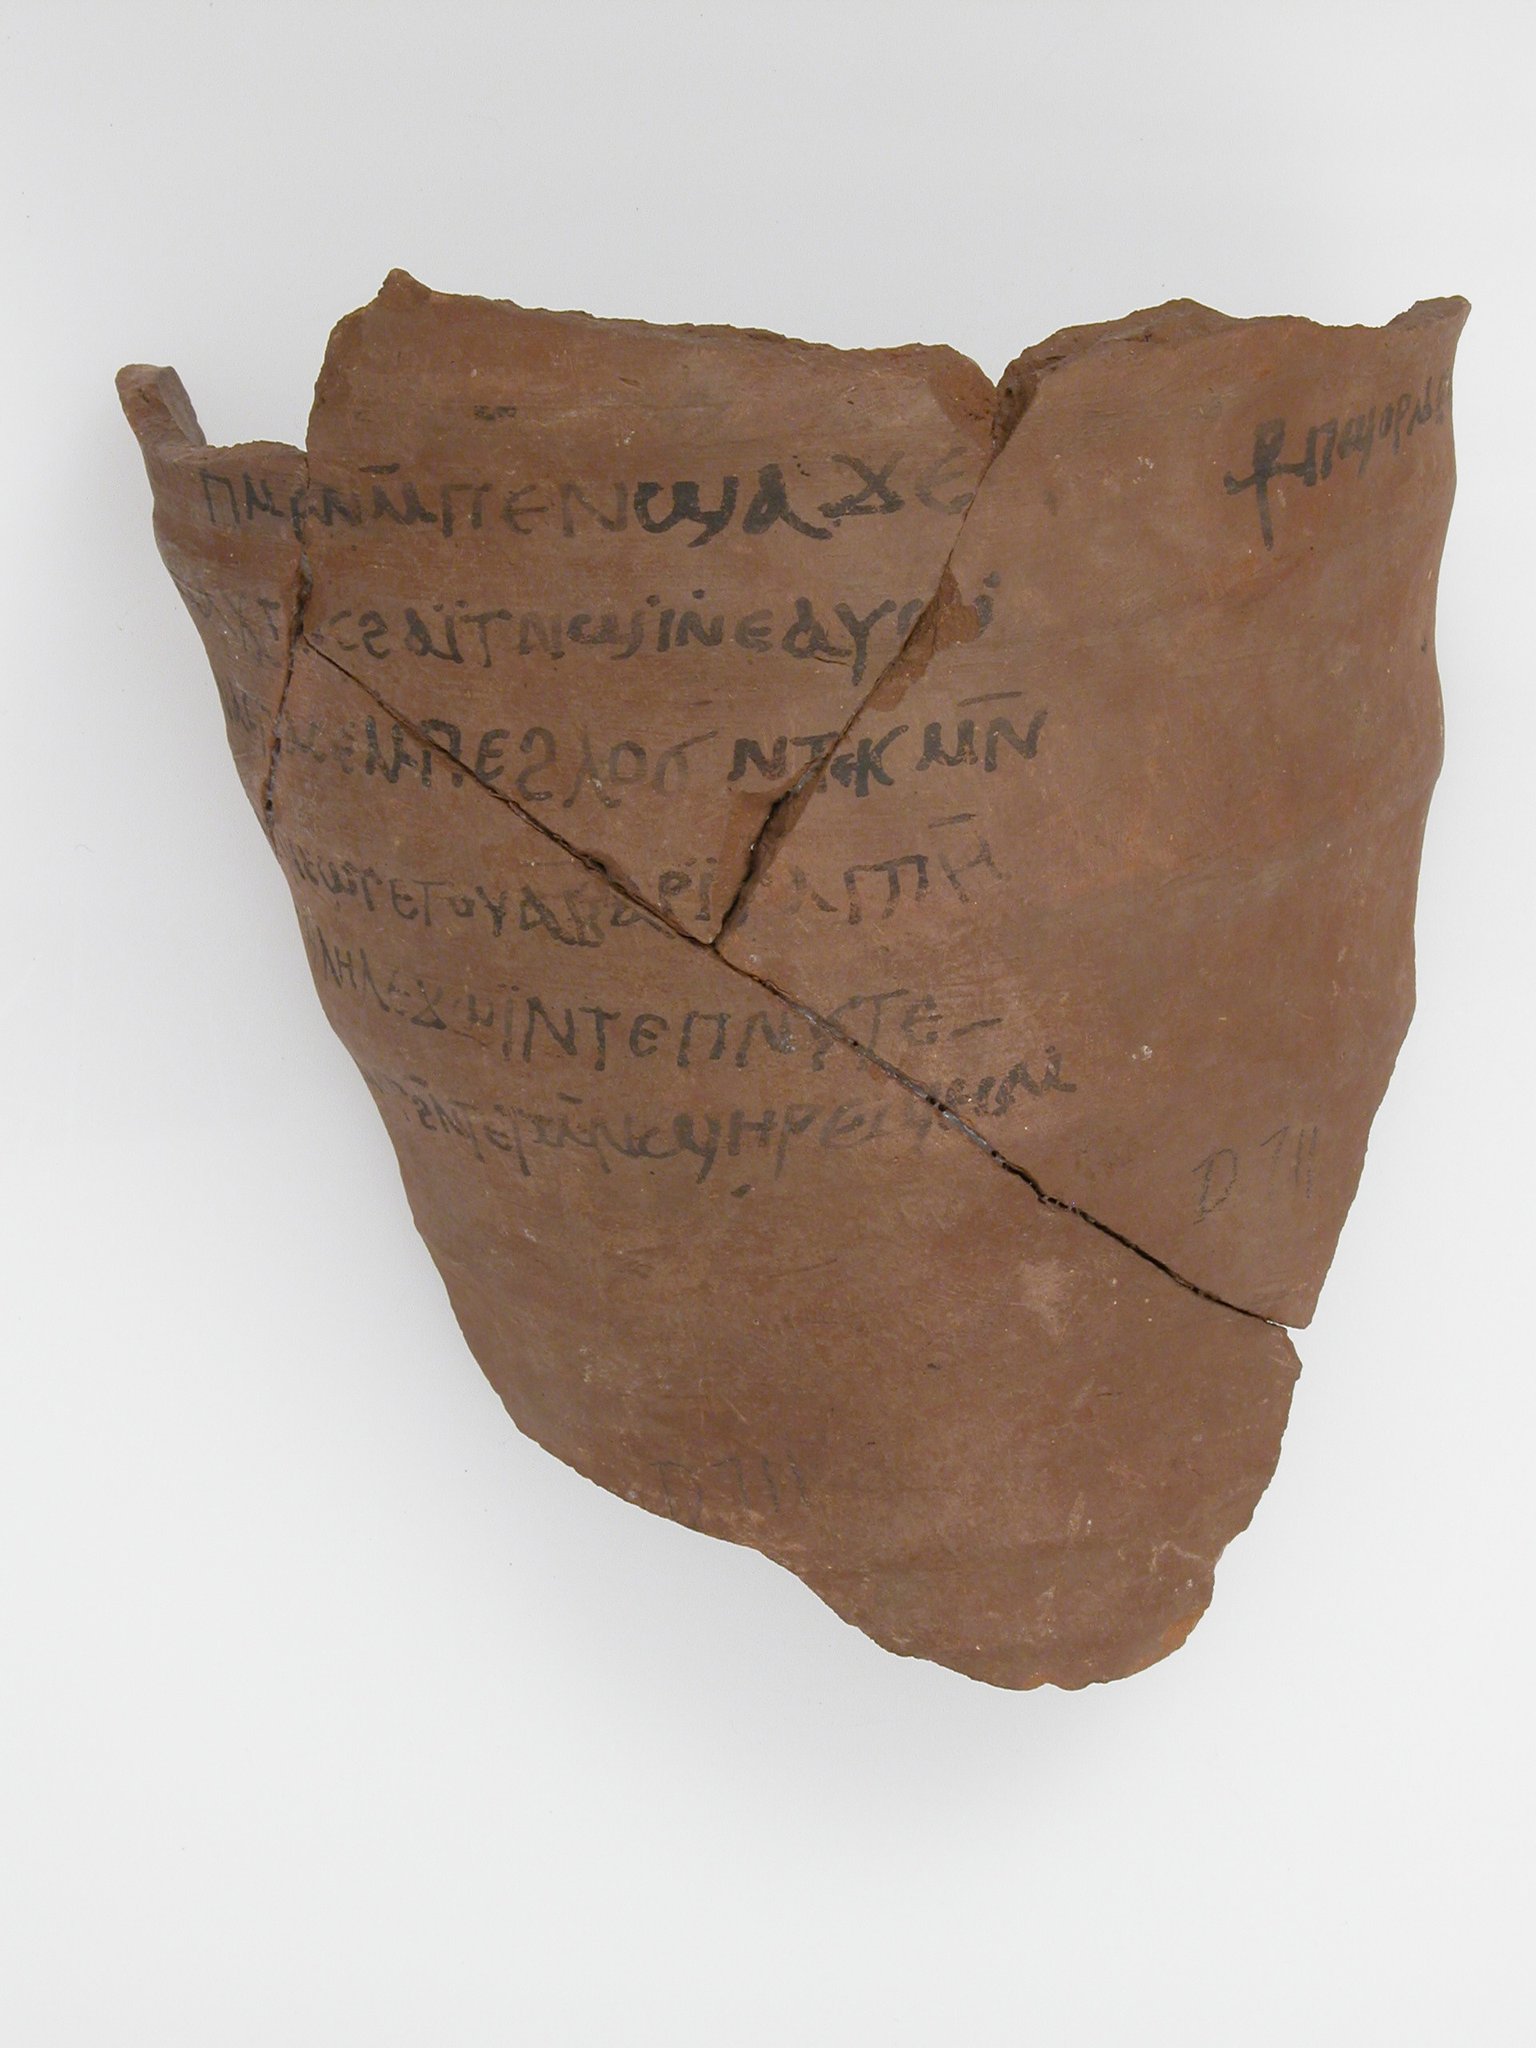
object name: ostrakon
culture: coptic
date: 601-700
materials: ink, pottery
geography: egypt